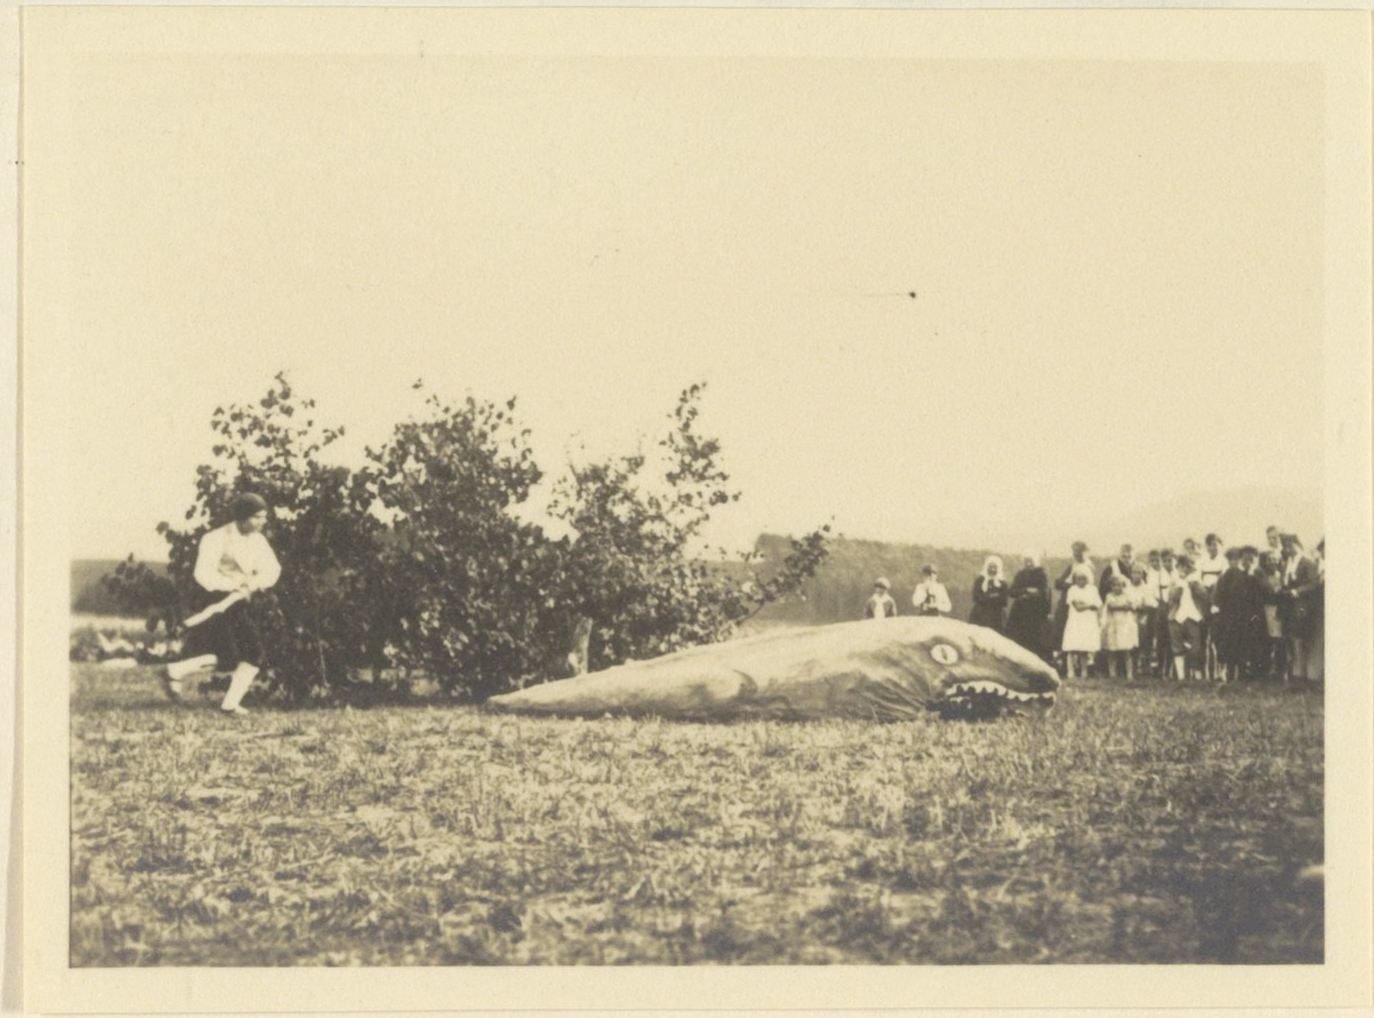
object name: photograph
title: Jonge leerlingen van Hermannsberg, een nevenvestiging van Schule Schloss Salem, tijdens een uitvoering in de openlucht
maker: Anonymous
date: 1929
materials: photographic support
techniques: gelatin silver print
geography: hermannsberg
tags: performance, theatre, theatrical performance, historical costume, education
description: Onderdeel van Fotoalbum van Schule Schloss Salem.